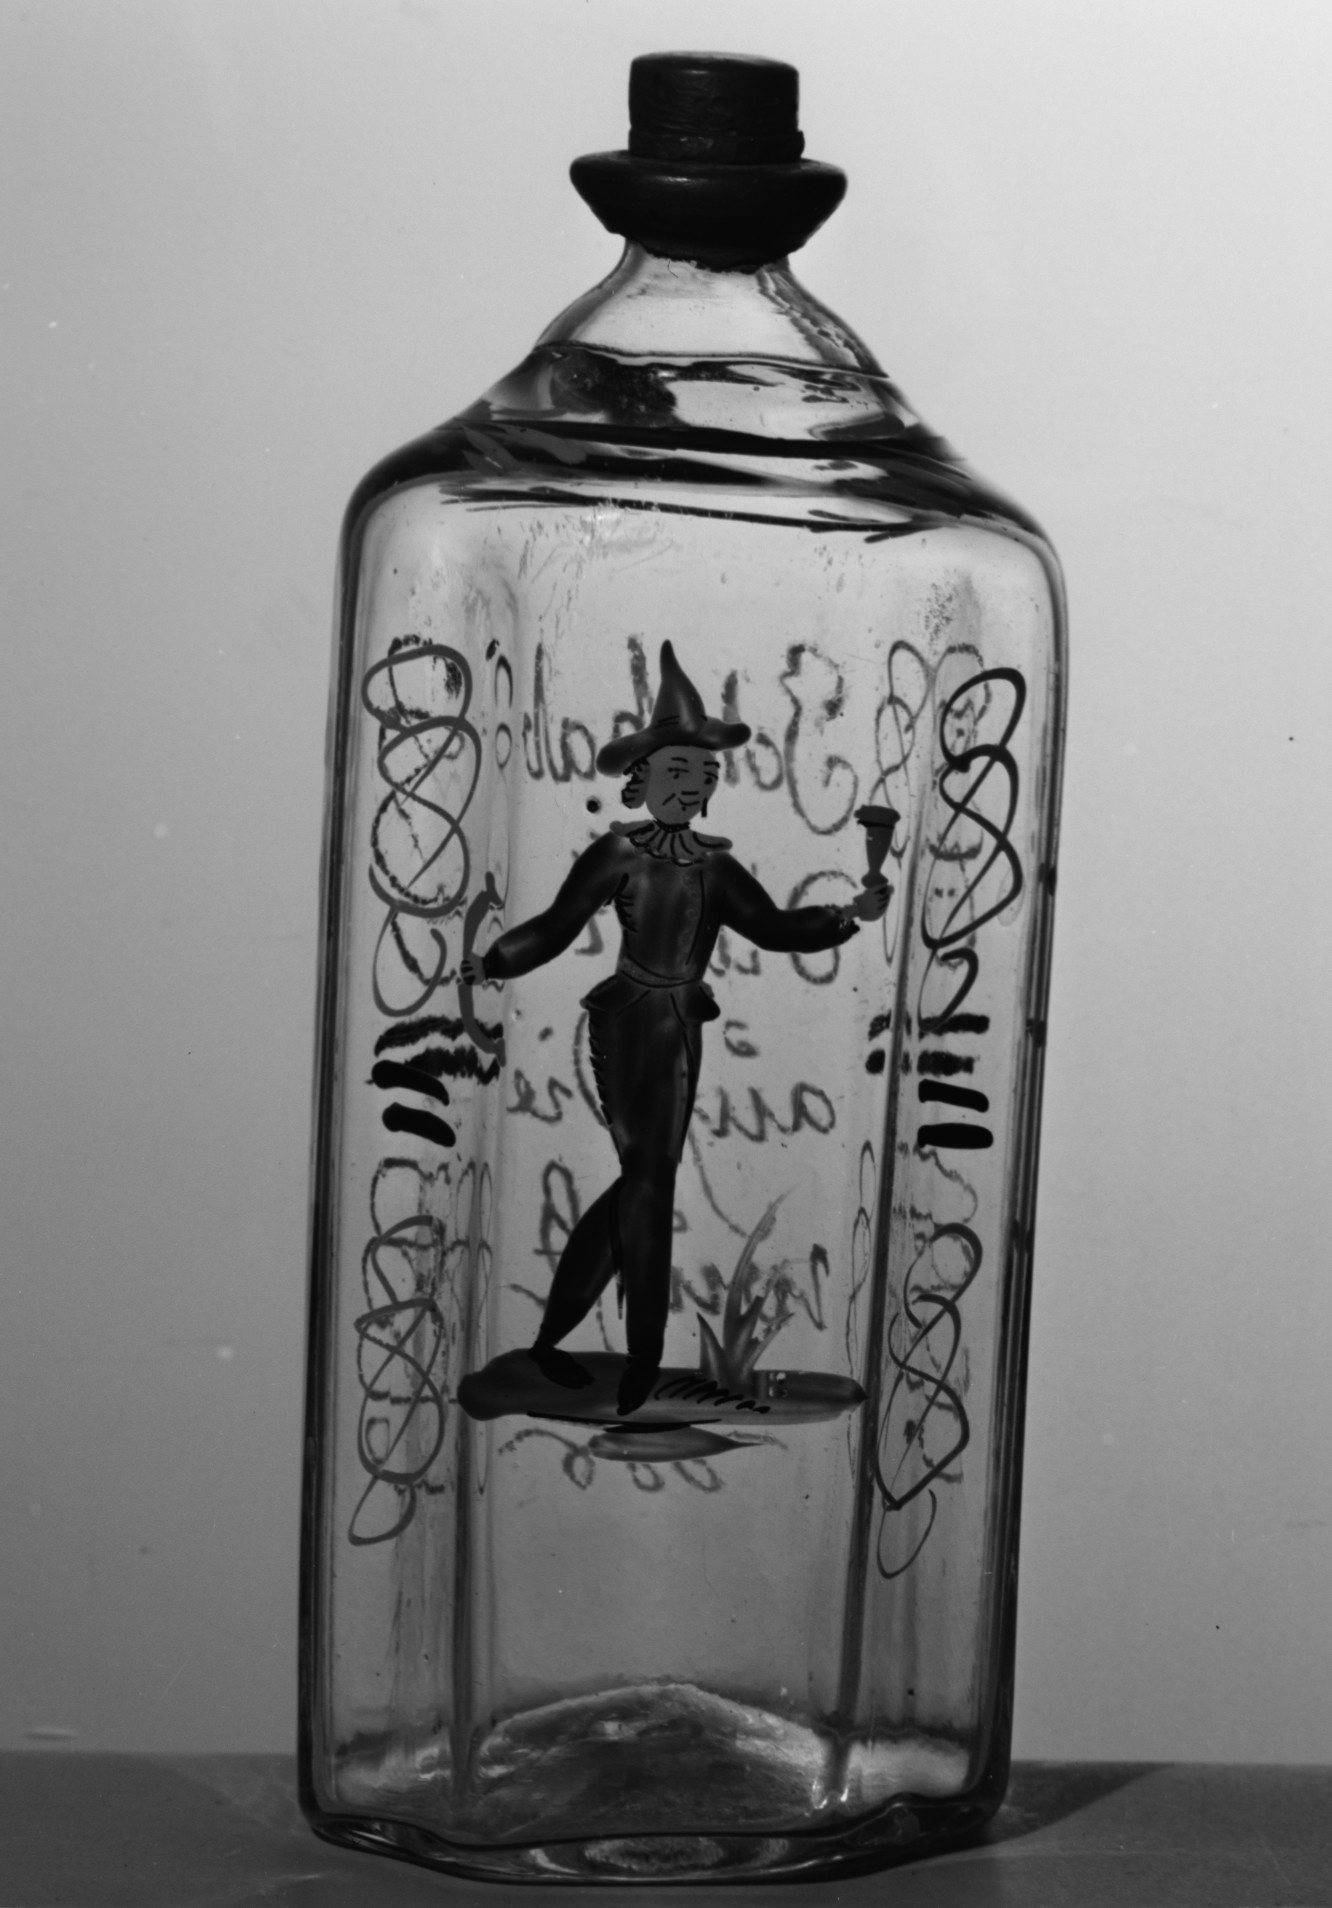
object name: bottle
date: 1701-1800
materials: glass, pewter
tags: men